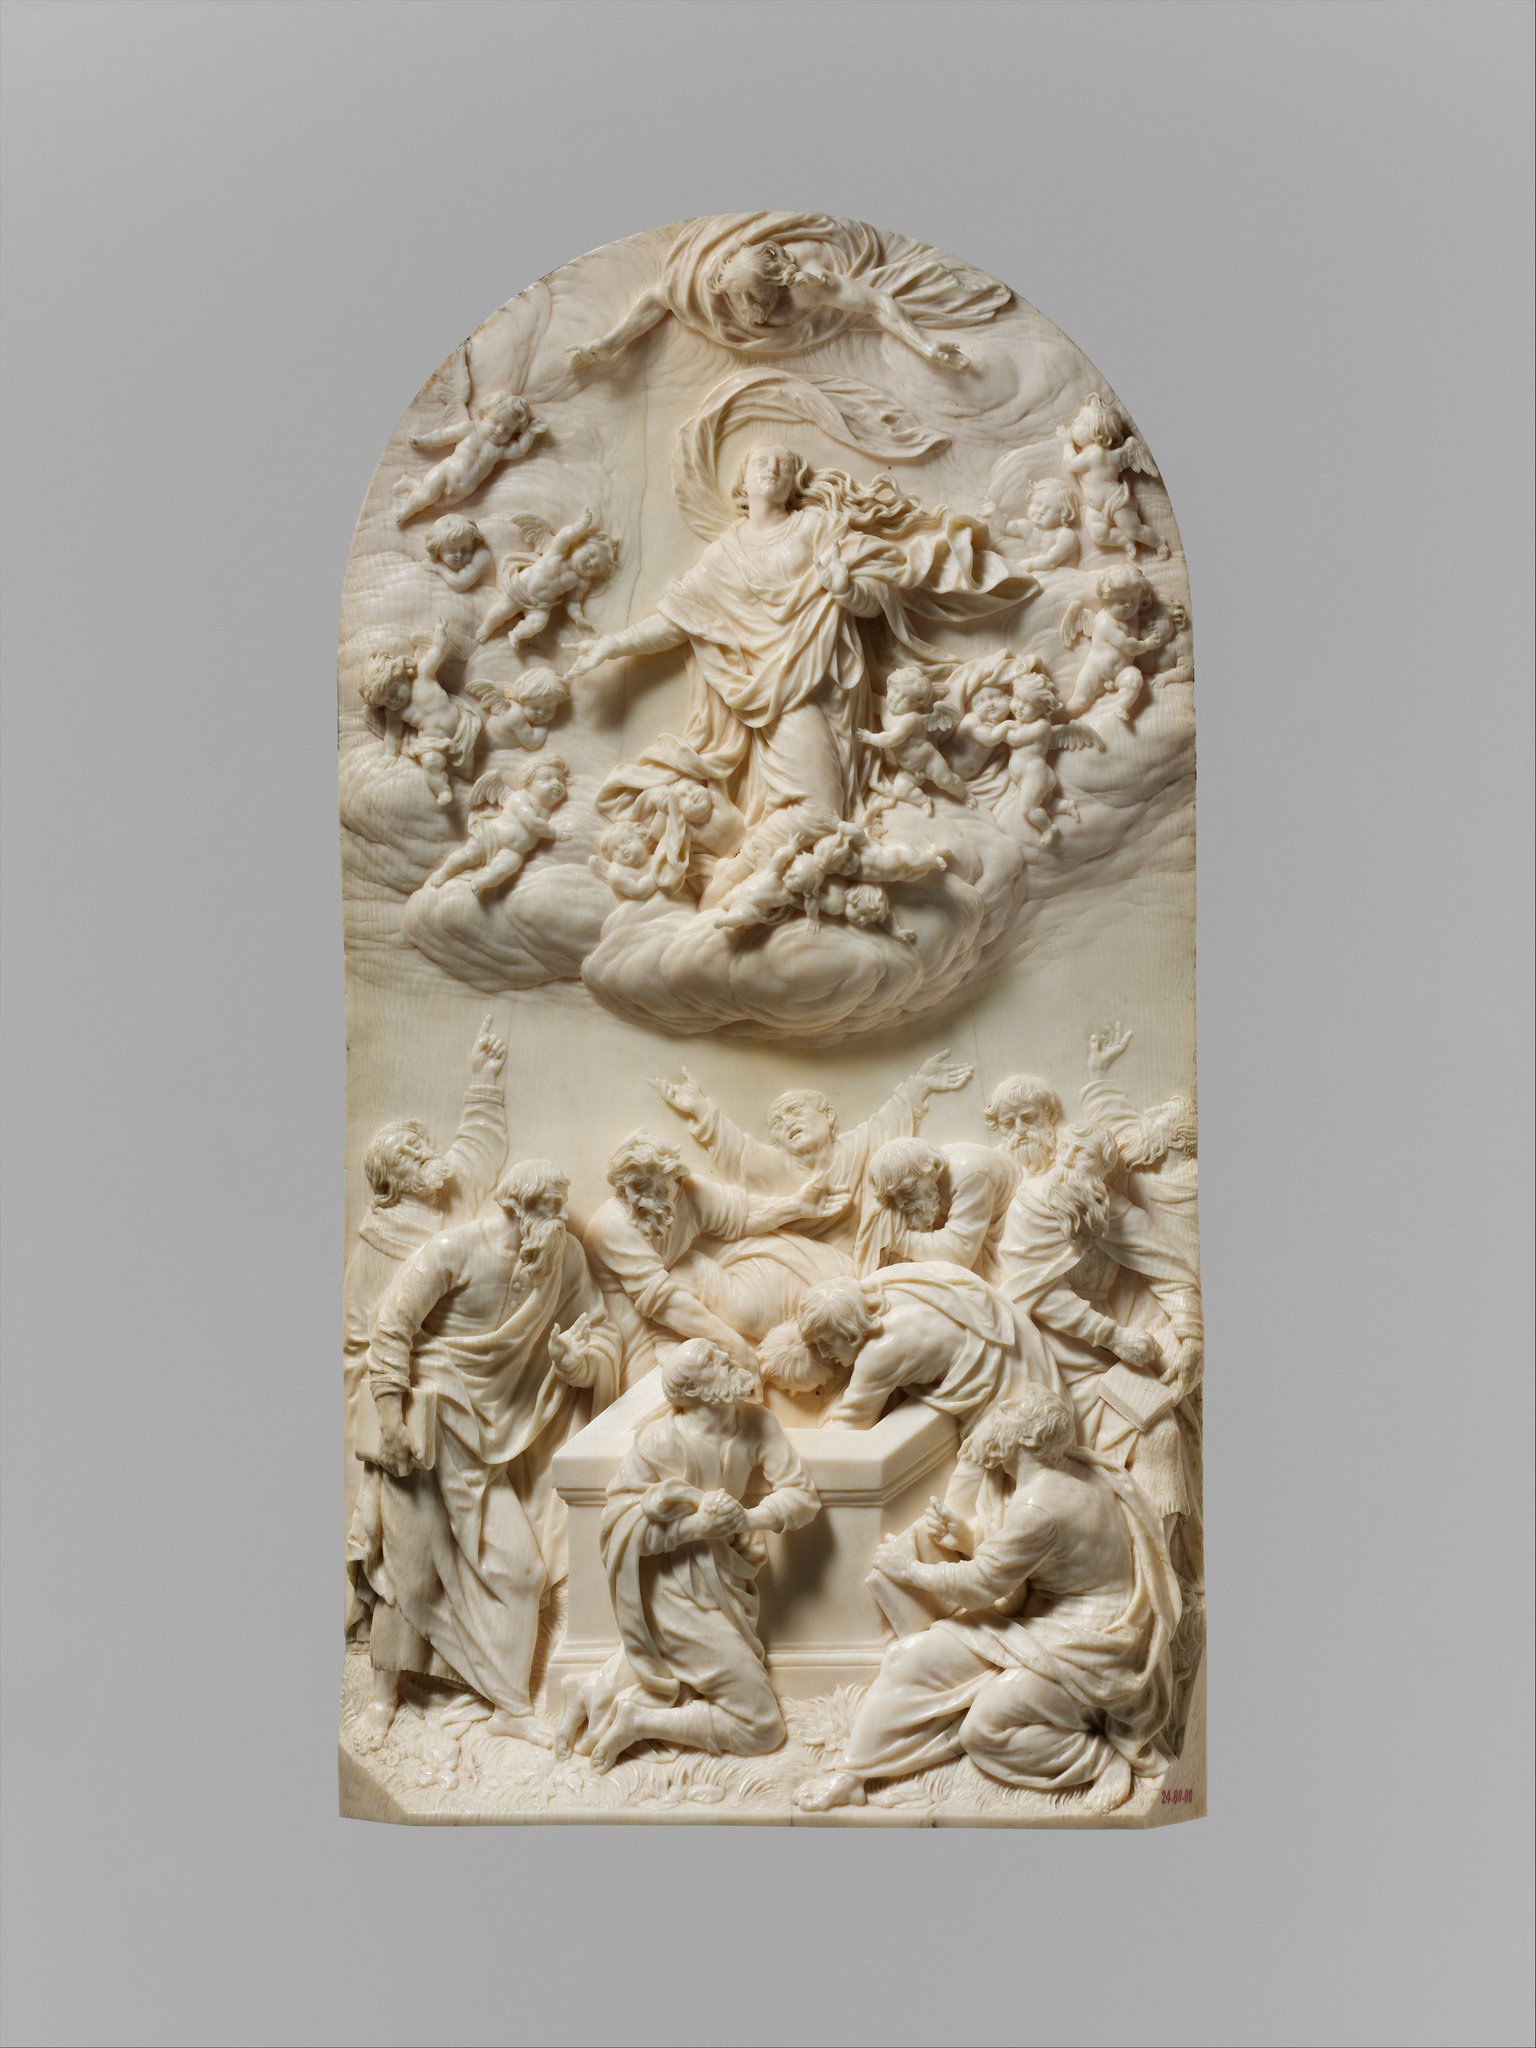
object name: plaque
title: Assumption of the Virgin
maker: adam lenckhart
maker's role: artist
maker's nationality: german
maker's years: 1610-1661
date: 1632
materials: ivory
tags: men,angels,virgin mary,assumption of the virgin